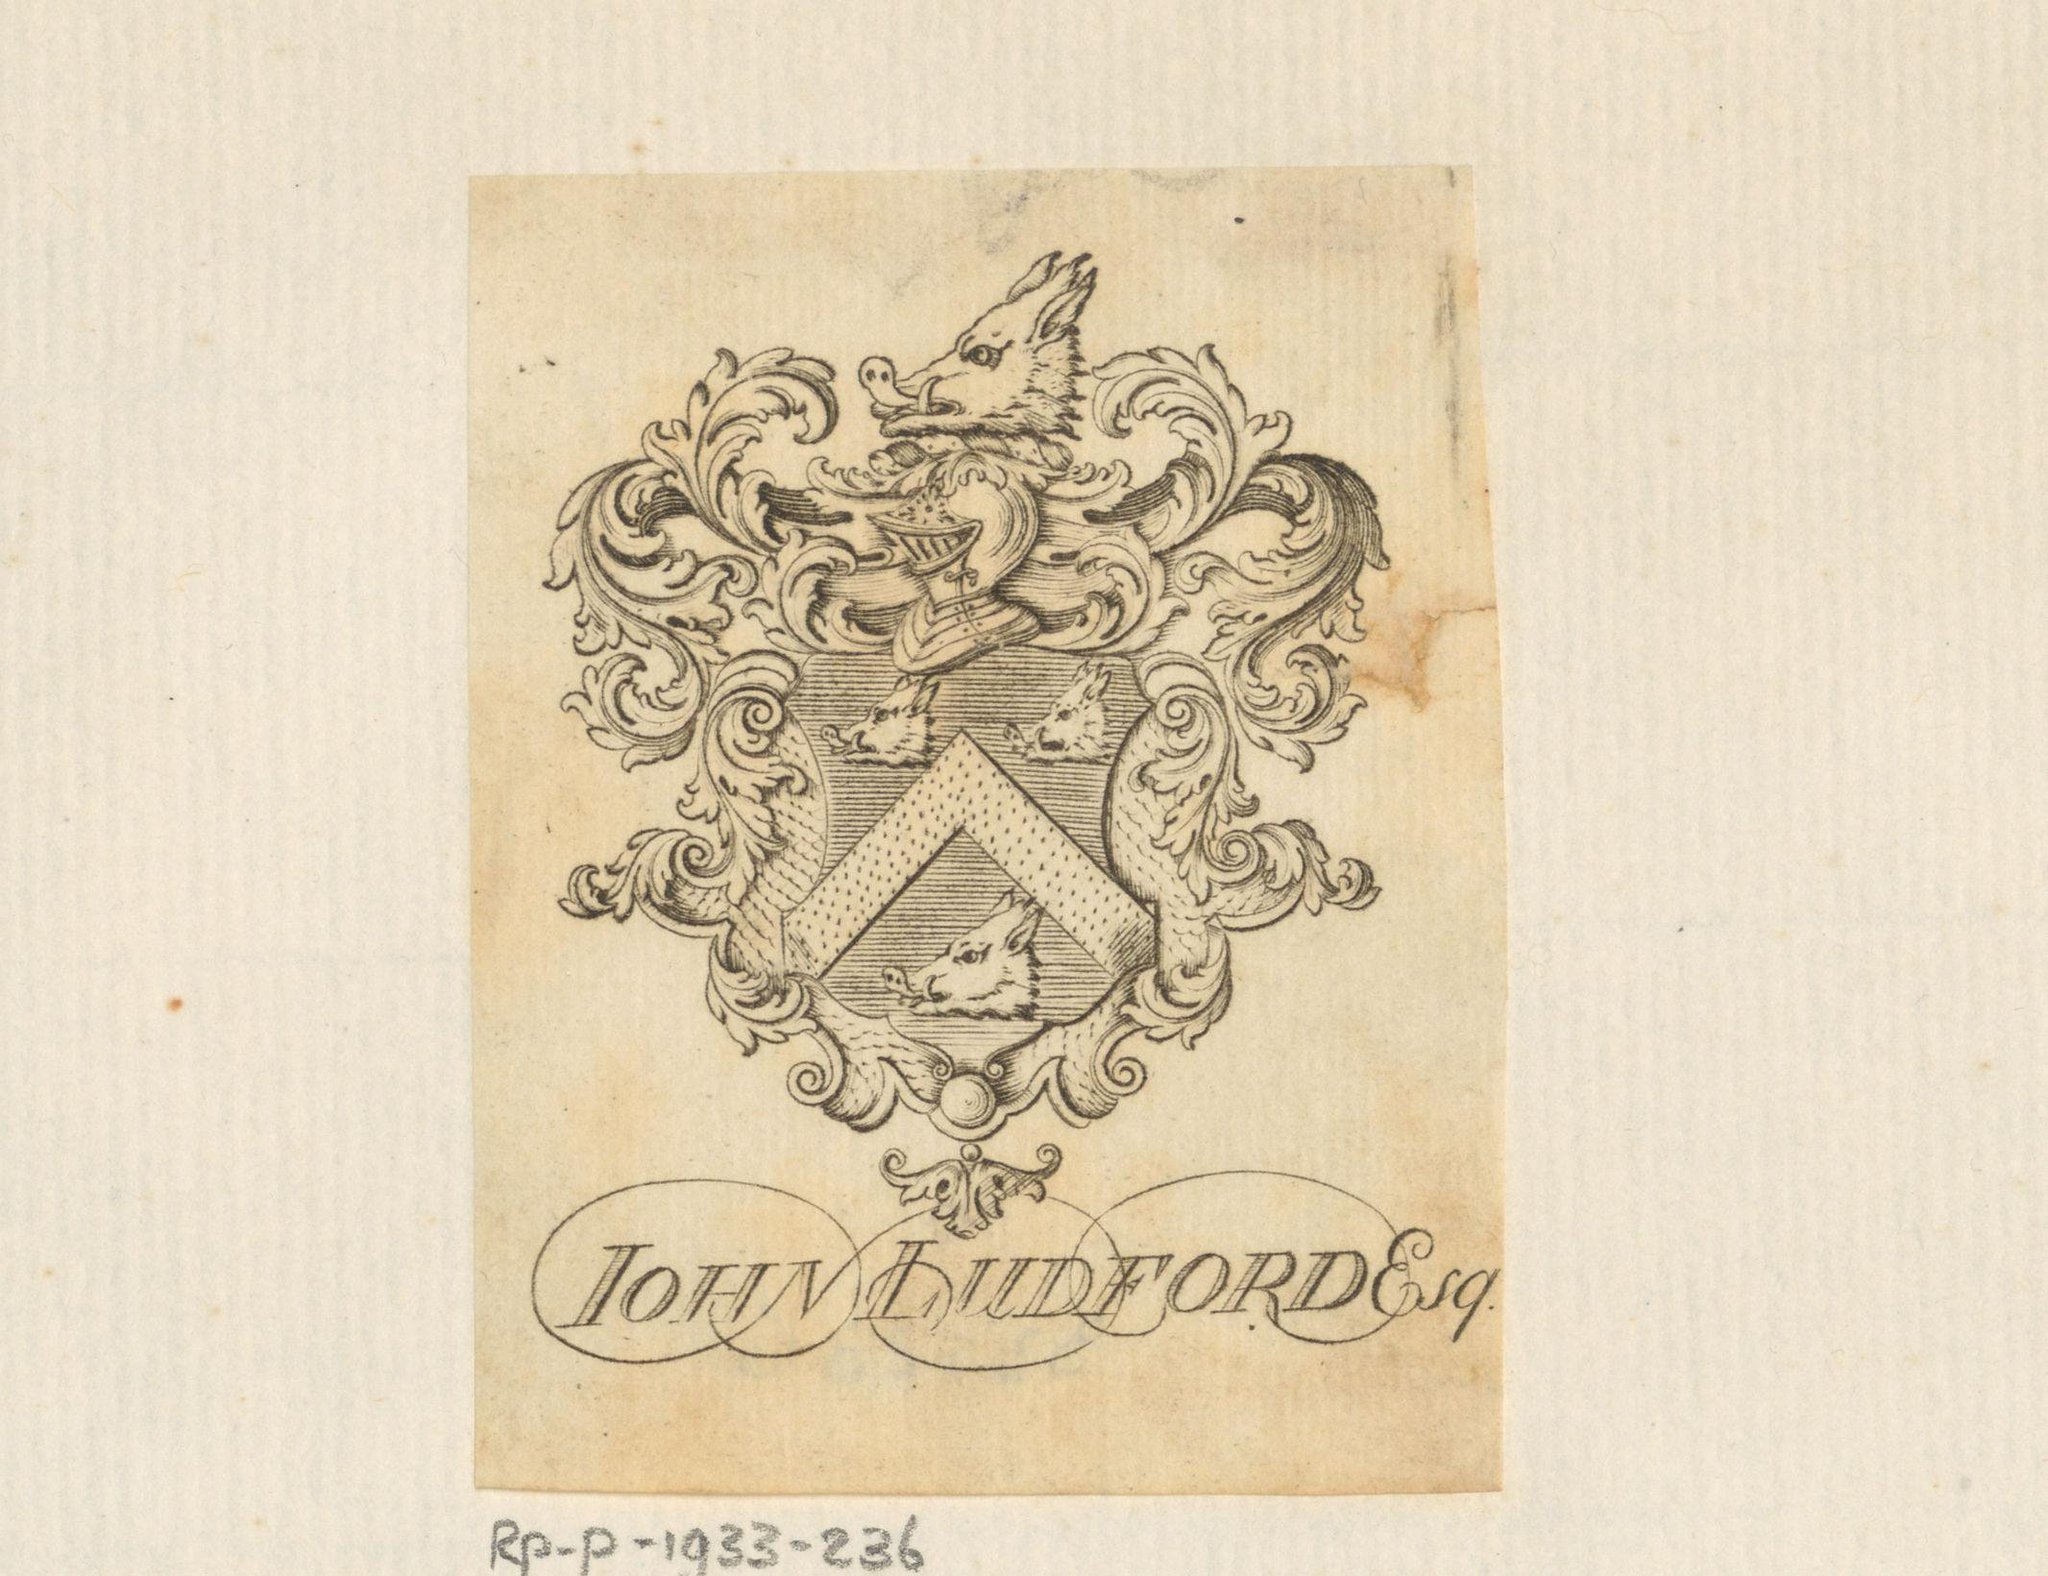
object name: bookplate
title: Ex libris van John Ludford Esq.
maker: Anonymous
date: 1700-1750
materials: paper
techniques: engraving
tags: armorial bearing, heraldry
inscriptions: collector's mark: Lugt 2760